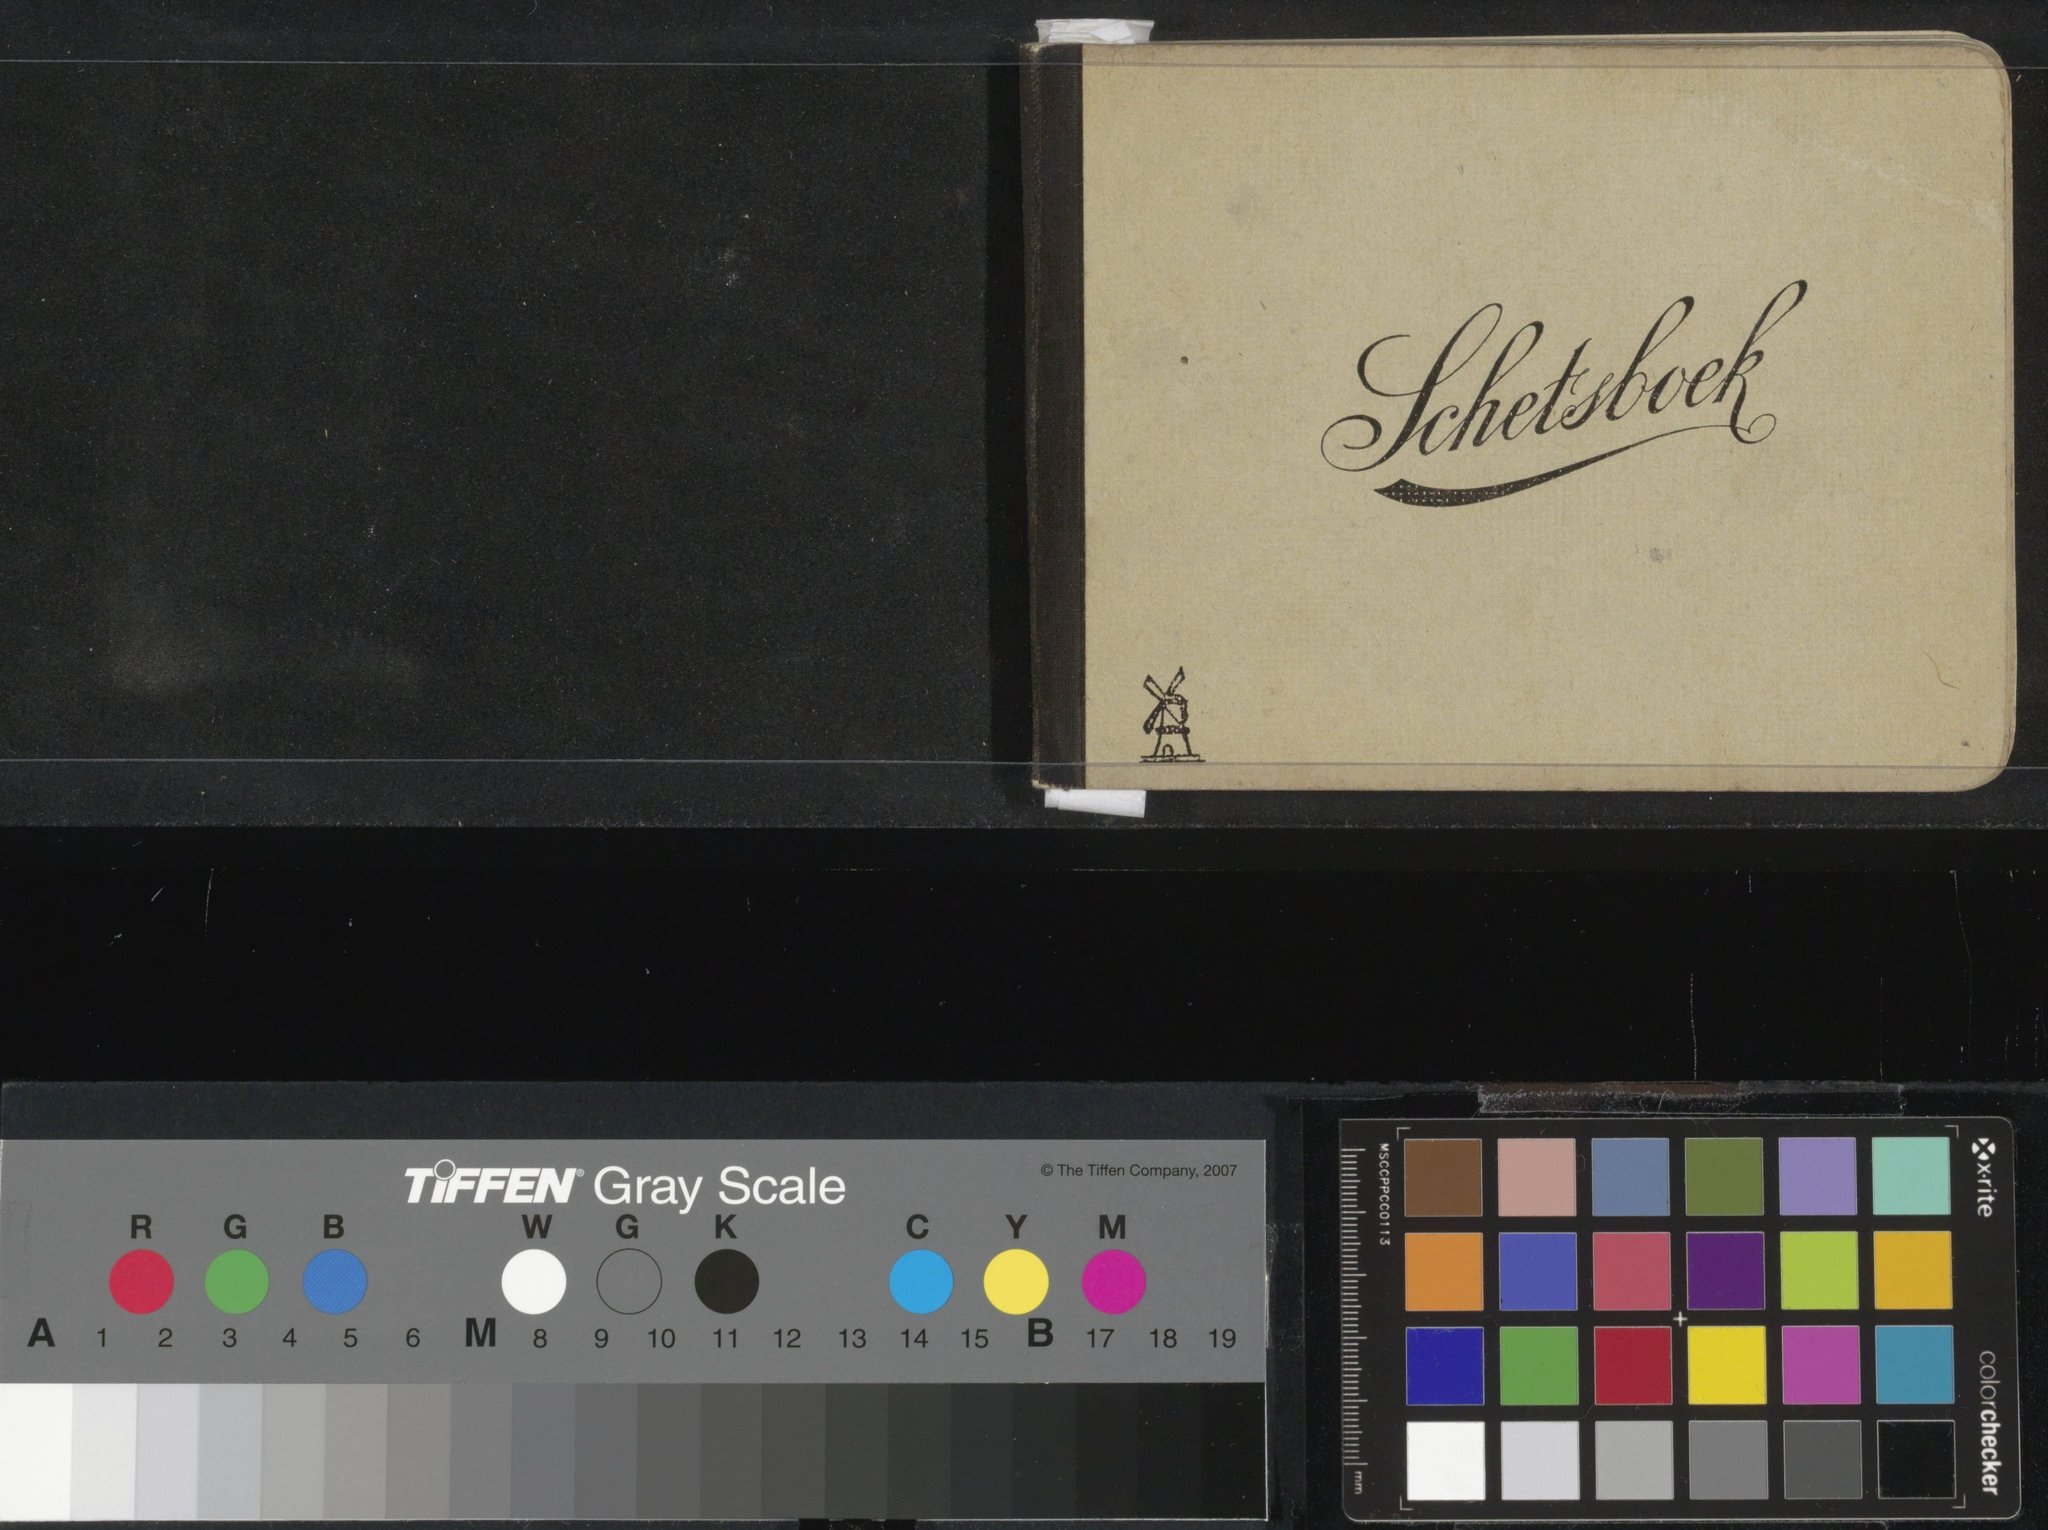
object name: sketchbook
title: Schetsboek met 33 bladen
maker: johan antonie de jonge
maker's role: draughtsman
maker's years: 1864-1927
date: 1884-1927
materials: cardboard, chalk, ink, linen, paper, pencil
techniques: stumping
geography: south holland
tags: beach (as place of recreation), dune coast, coast, beach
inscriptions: collector's mark: Lugt 2228, inscription: ‘Schetsboek’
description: Schetsboek bestaande uit 33 bladen met duinlandschappen, bossen, strandgezichten en figuurstudies. Op de kaft een molen.